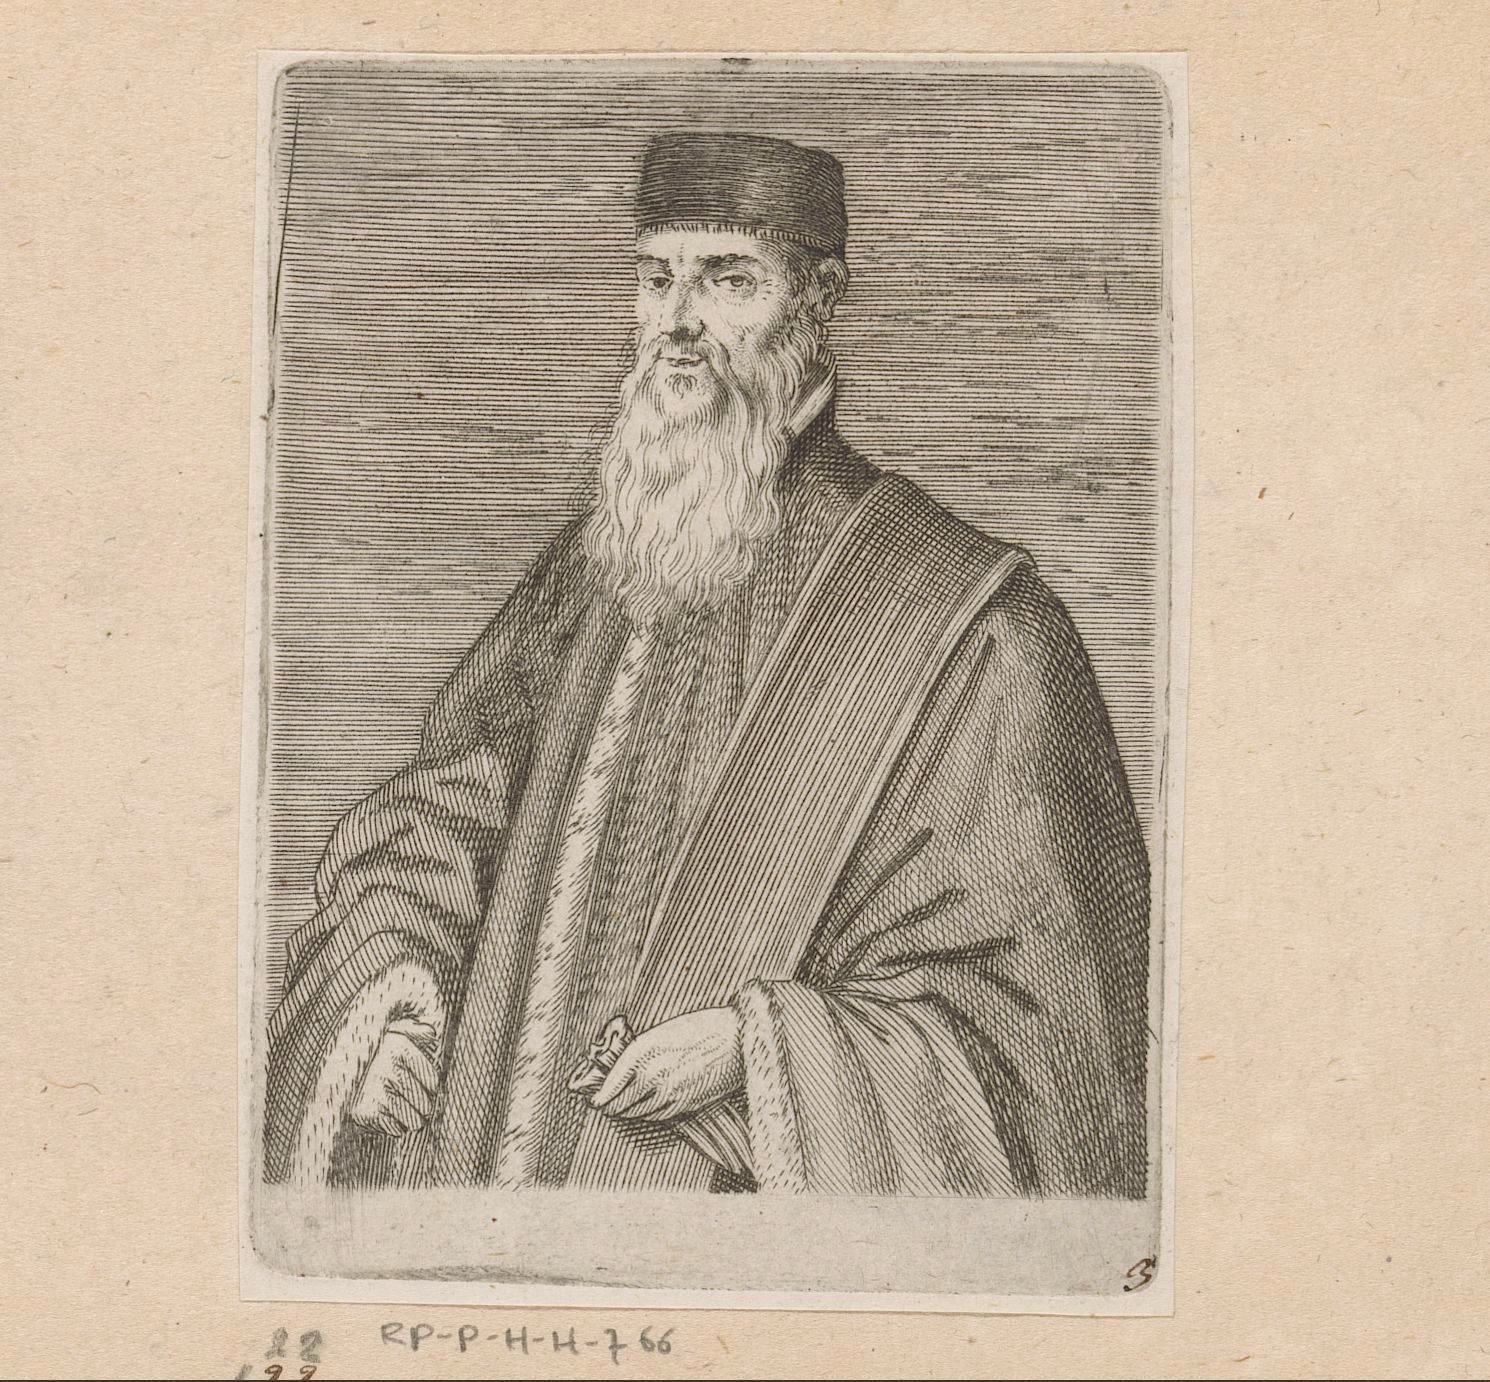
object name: print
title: Man met een baard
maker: francesco villamena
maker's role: draughtsman, painter, print maker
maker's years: 1566-1624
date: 1576-1624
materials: paper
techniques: engraving, intaglio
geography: italy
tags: anonymous historical person portrayed, folk costume, regional costume, beard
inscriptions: collector's mark: Lugt 10, number: ‘3’, collector's mark: Lugt 11